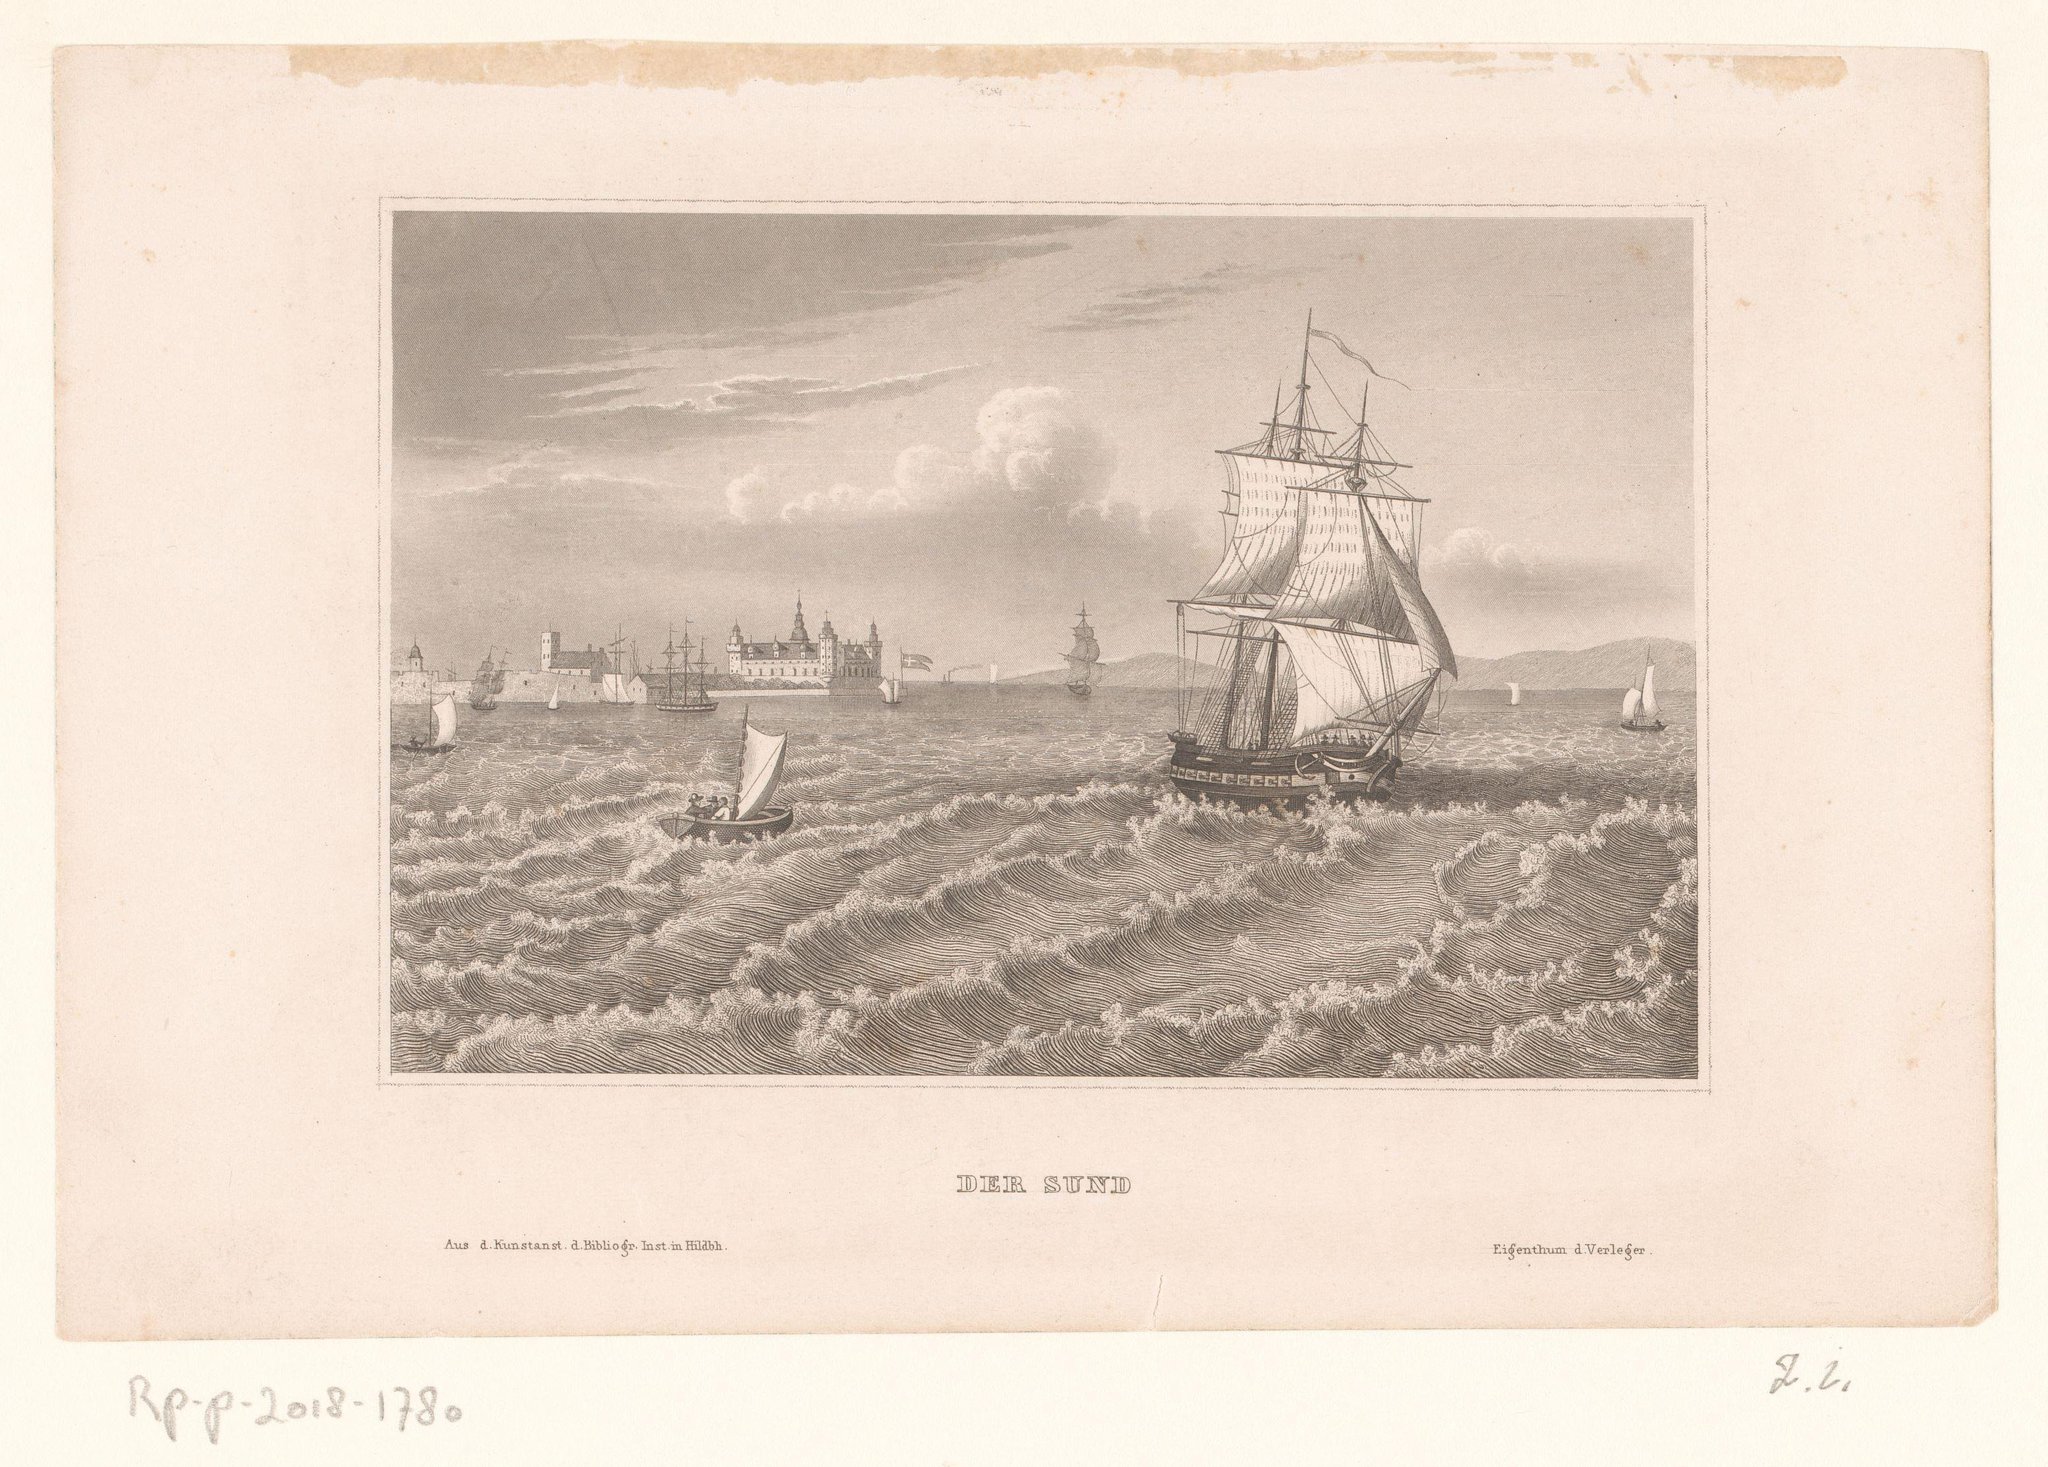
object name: print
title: Gezicht op de Sont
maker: Anonymous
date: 1828-1874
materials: paper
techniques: engraving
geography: hildburghausen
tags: straits, narrows, sailing-ship, sailing-boat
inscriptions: collector's mark: Lugt 2228